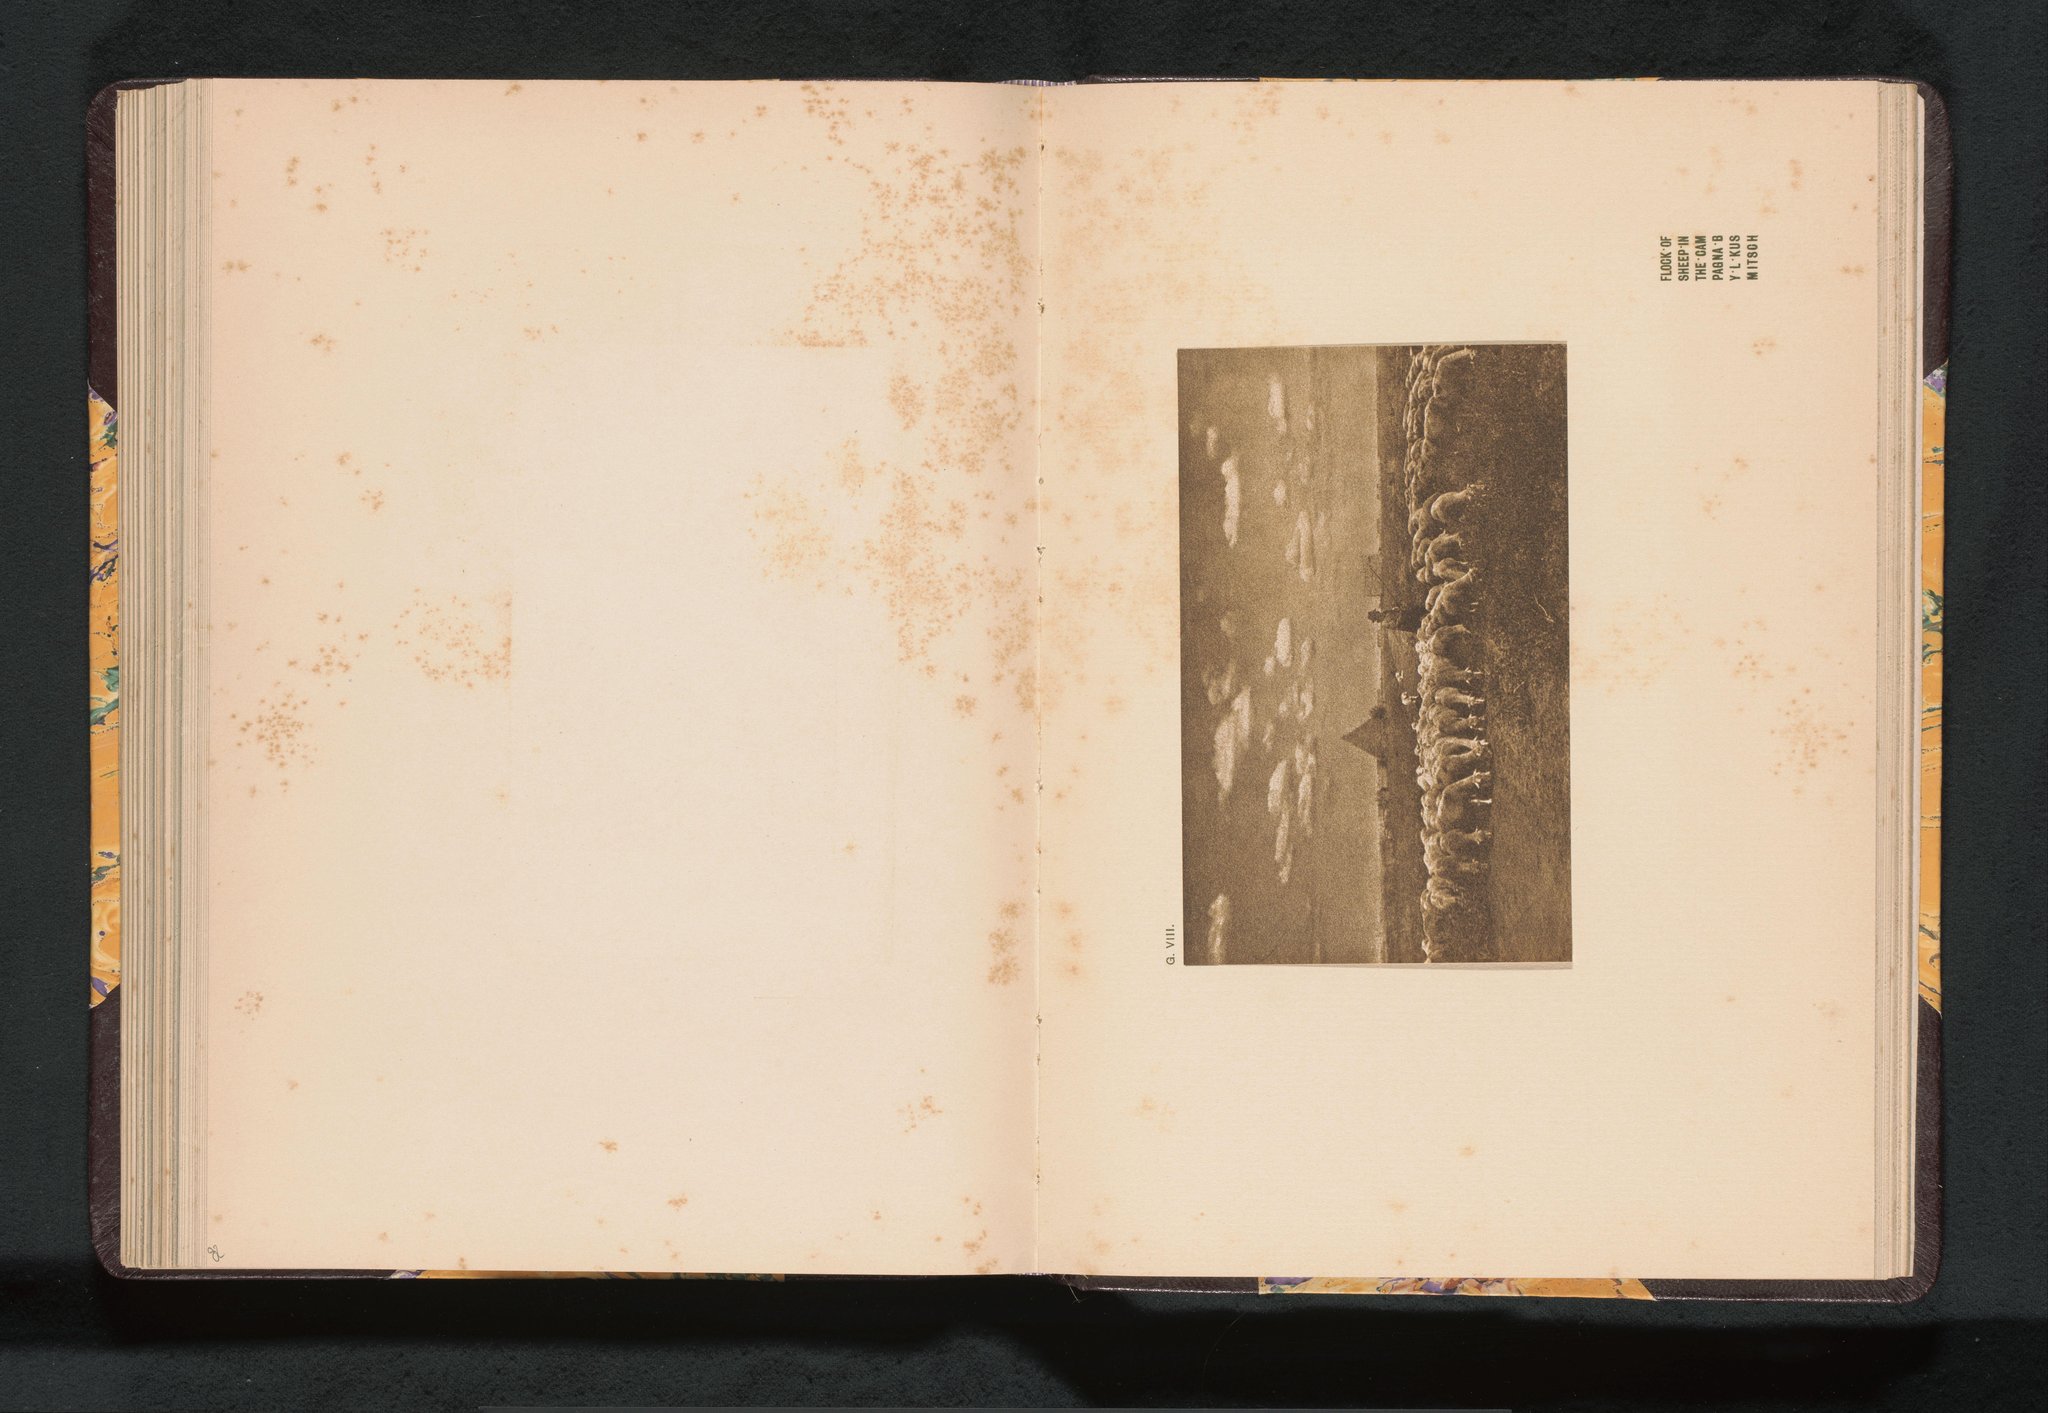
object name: photomechanical print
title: Schaapherder in Campagna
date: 1900-1905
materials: paper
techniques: autotype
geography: campagna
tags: herding, herdsman, herdswoman, shepherd, shepherdess, cowherd, etc., campagna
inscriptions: inscription: ‘G. VIII.’, inscription: ‘Flock of sheep in the Campagna by L. Kusmitsch’